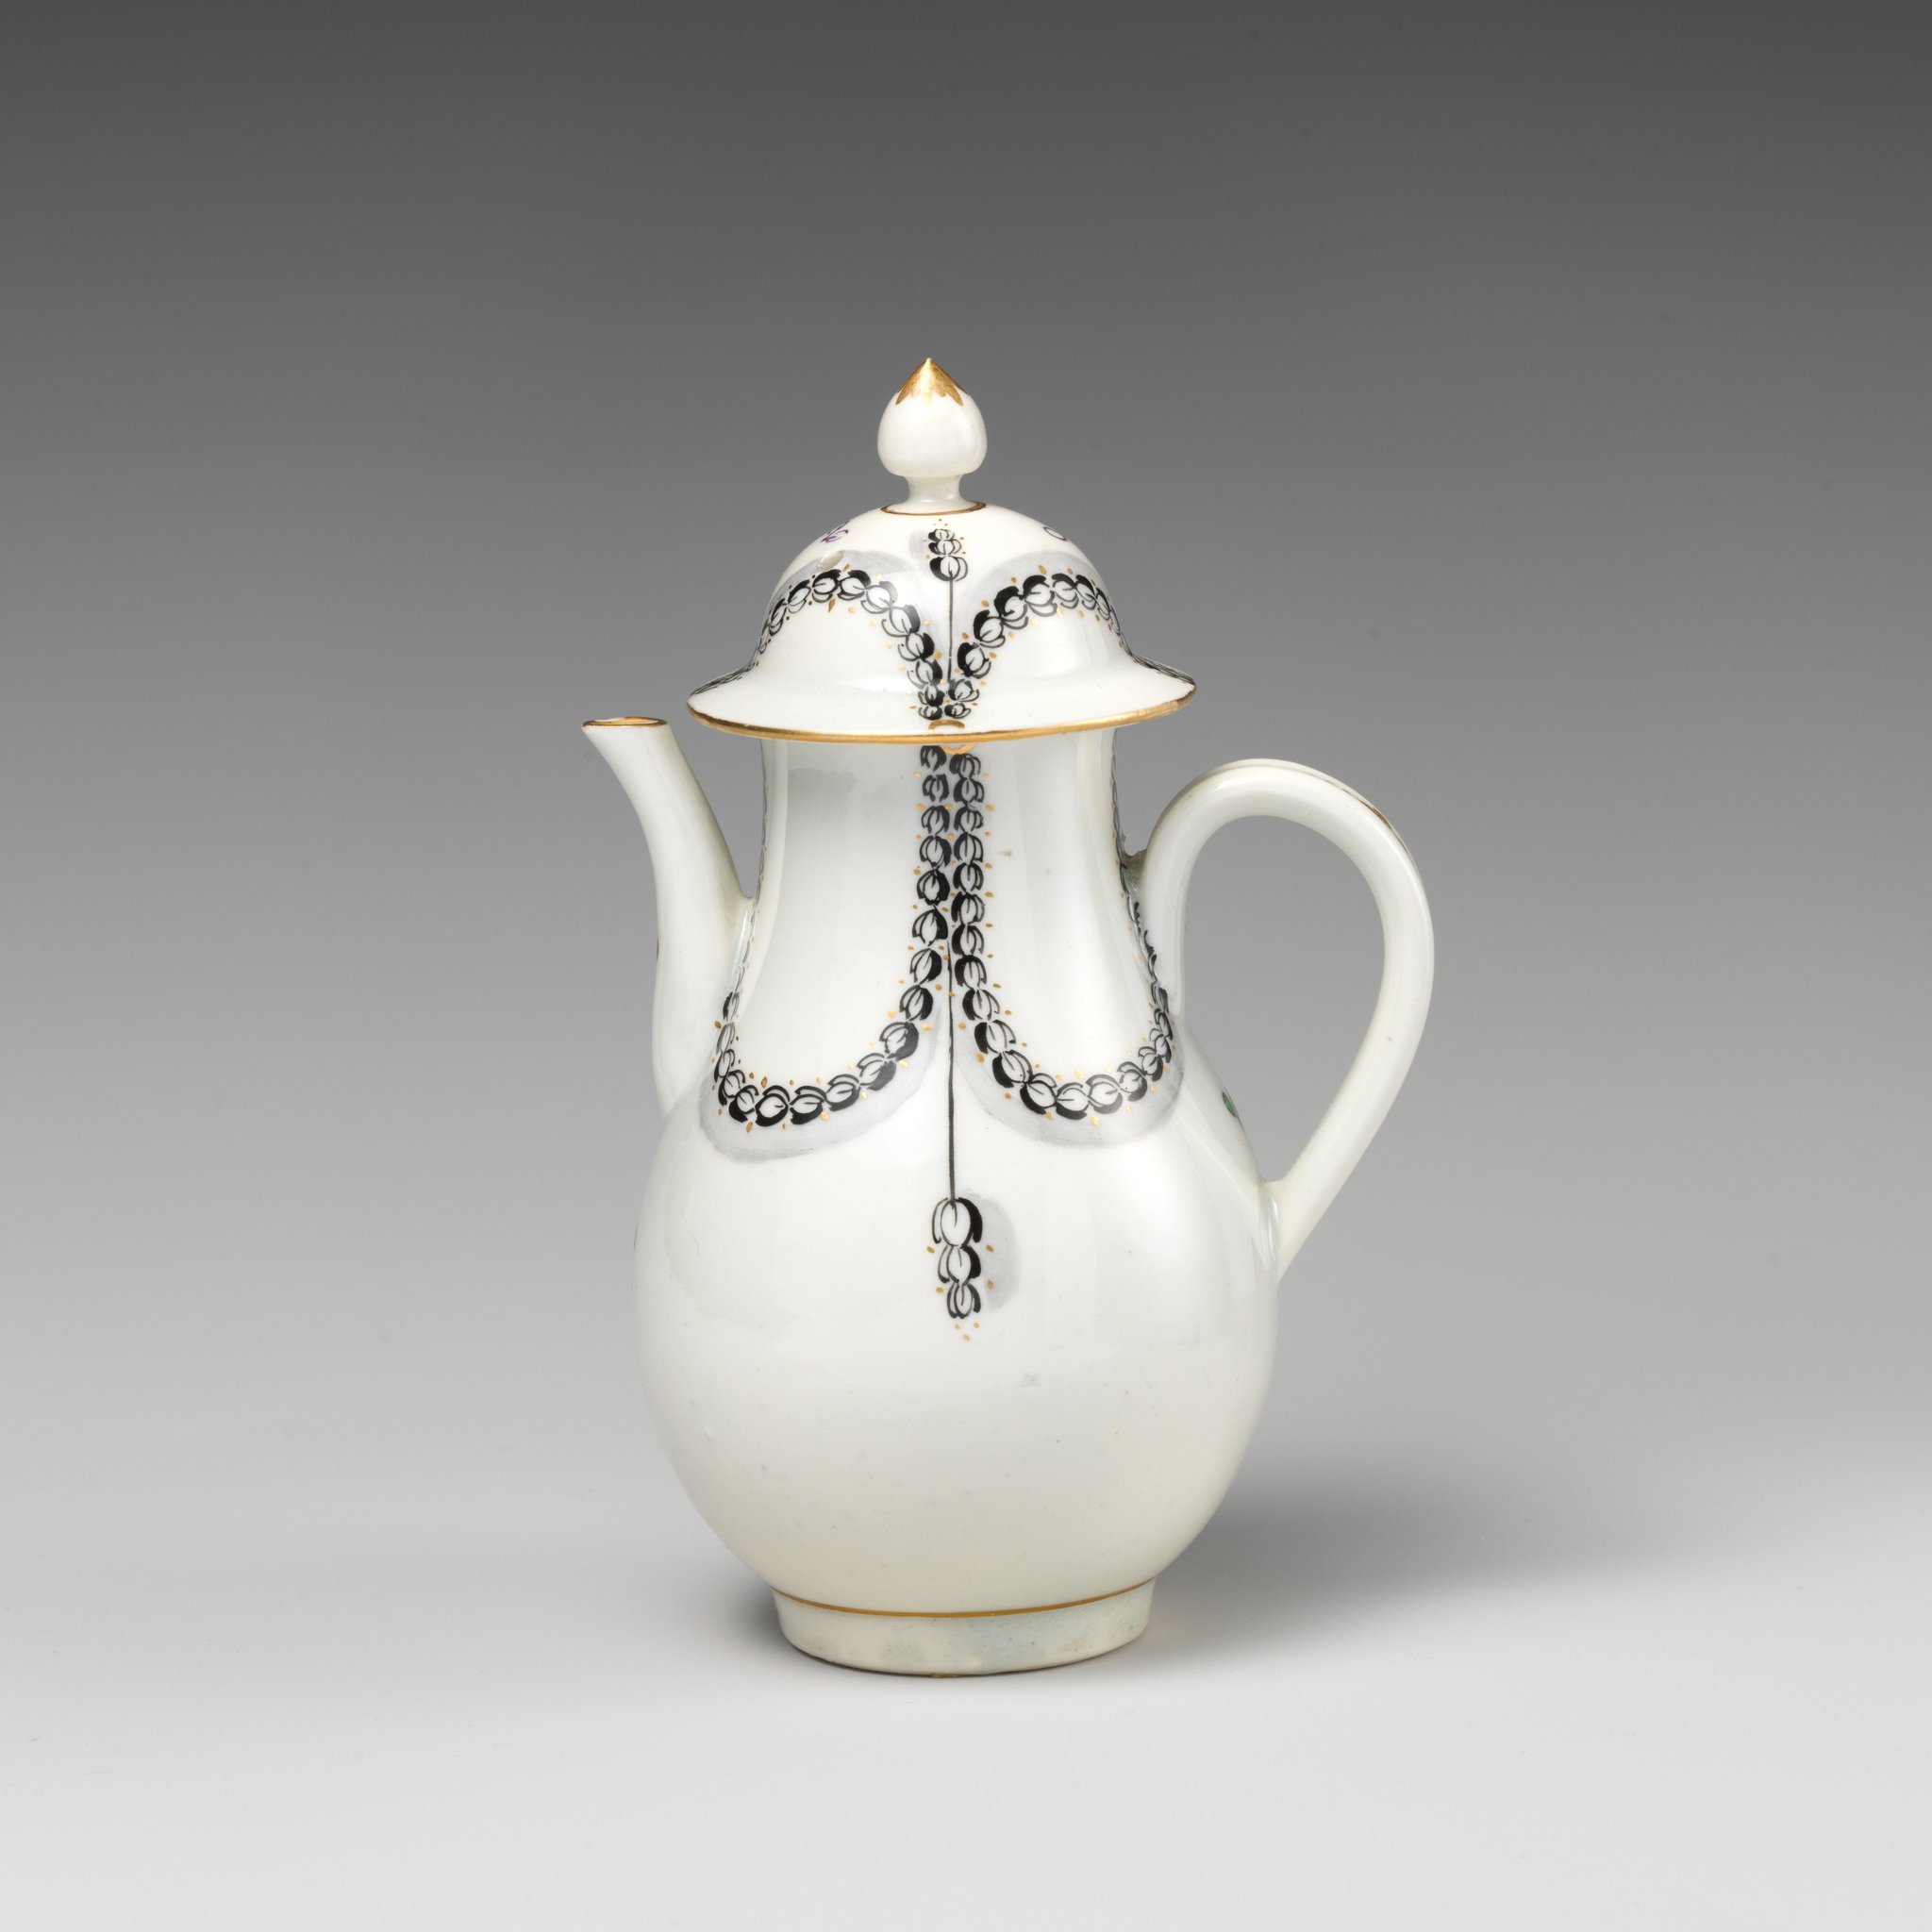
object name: coffeepot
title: Coffeepot (part of a service)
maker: caughley factory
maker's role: factory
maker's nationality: british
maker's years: 1772-1799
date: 1780-1790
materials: enamel, soft paste porcelain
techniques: gilding